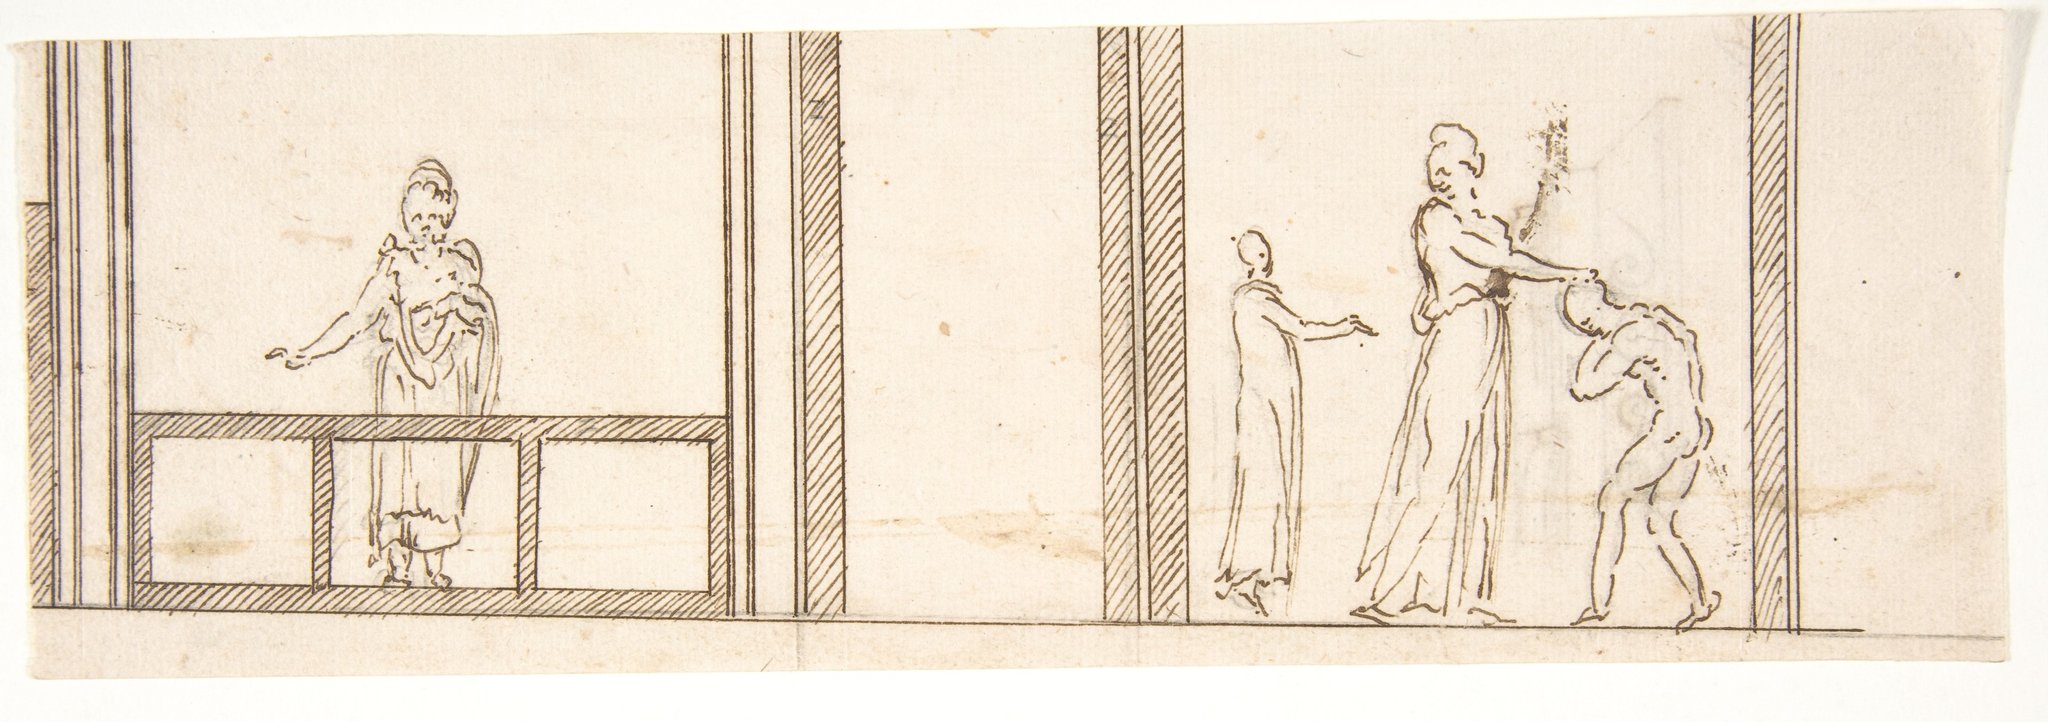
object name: collection ornament architecture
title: Unidentified building, ceiling or wall, painted frieze or decorative panels (recto) Unidentified building, cornice (verso)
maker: anonymous, french, 16th century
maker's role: draftsman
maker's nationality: french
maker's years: 1500-1600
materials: chalk, ink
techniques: incising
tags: women